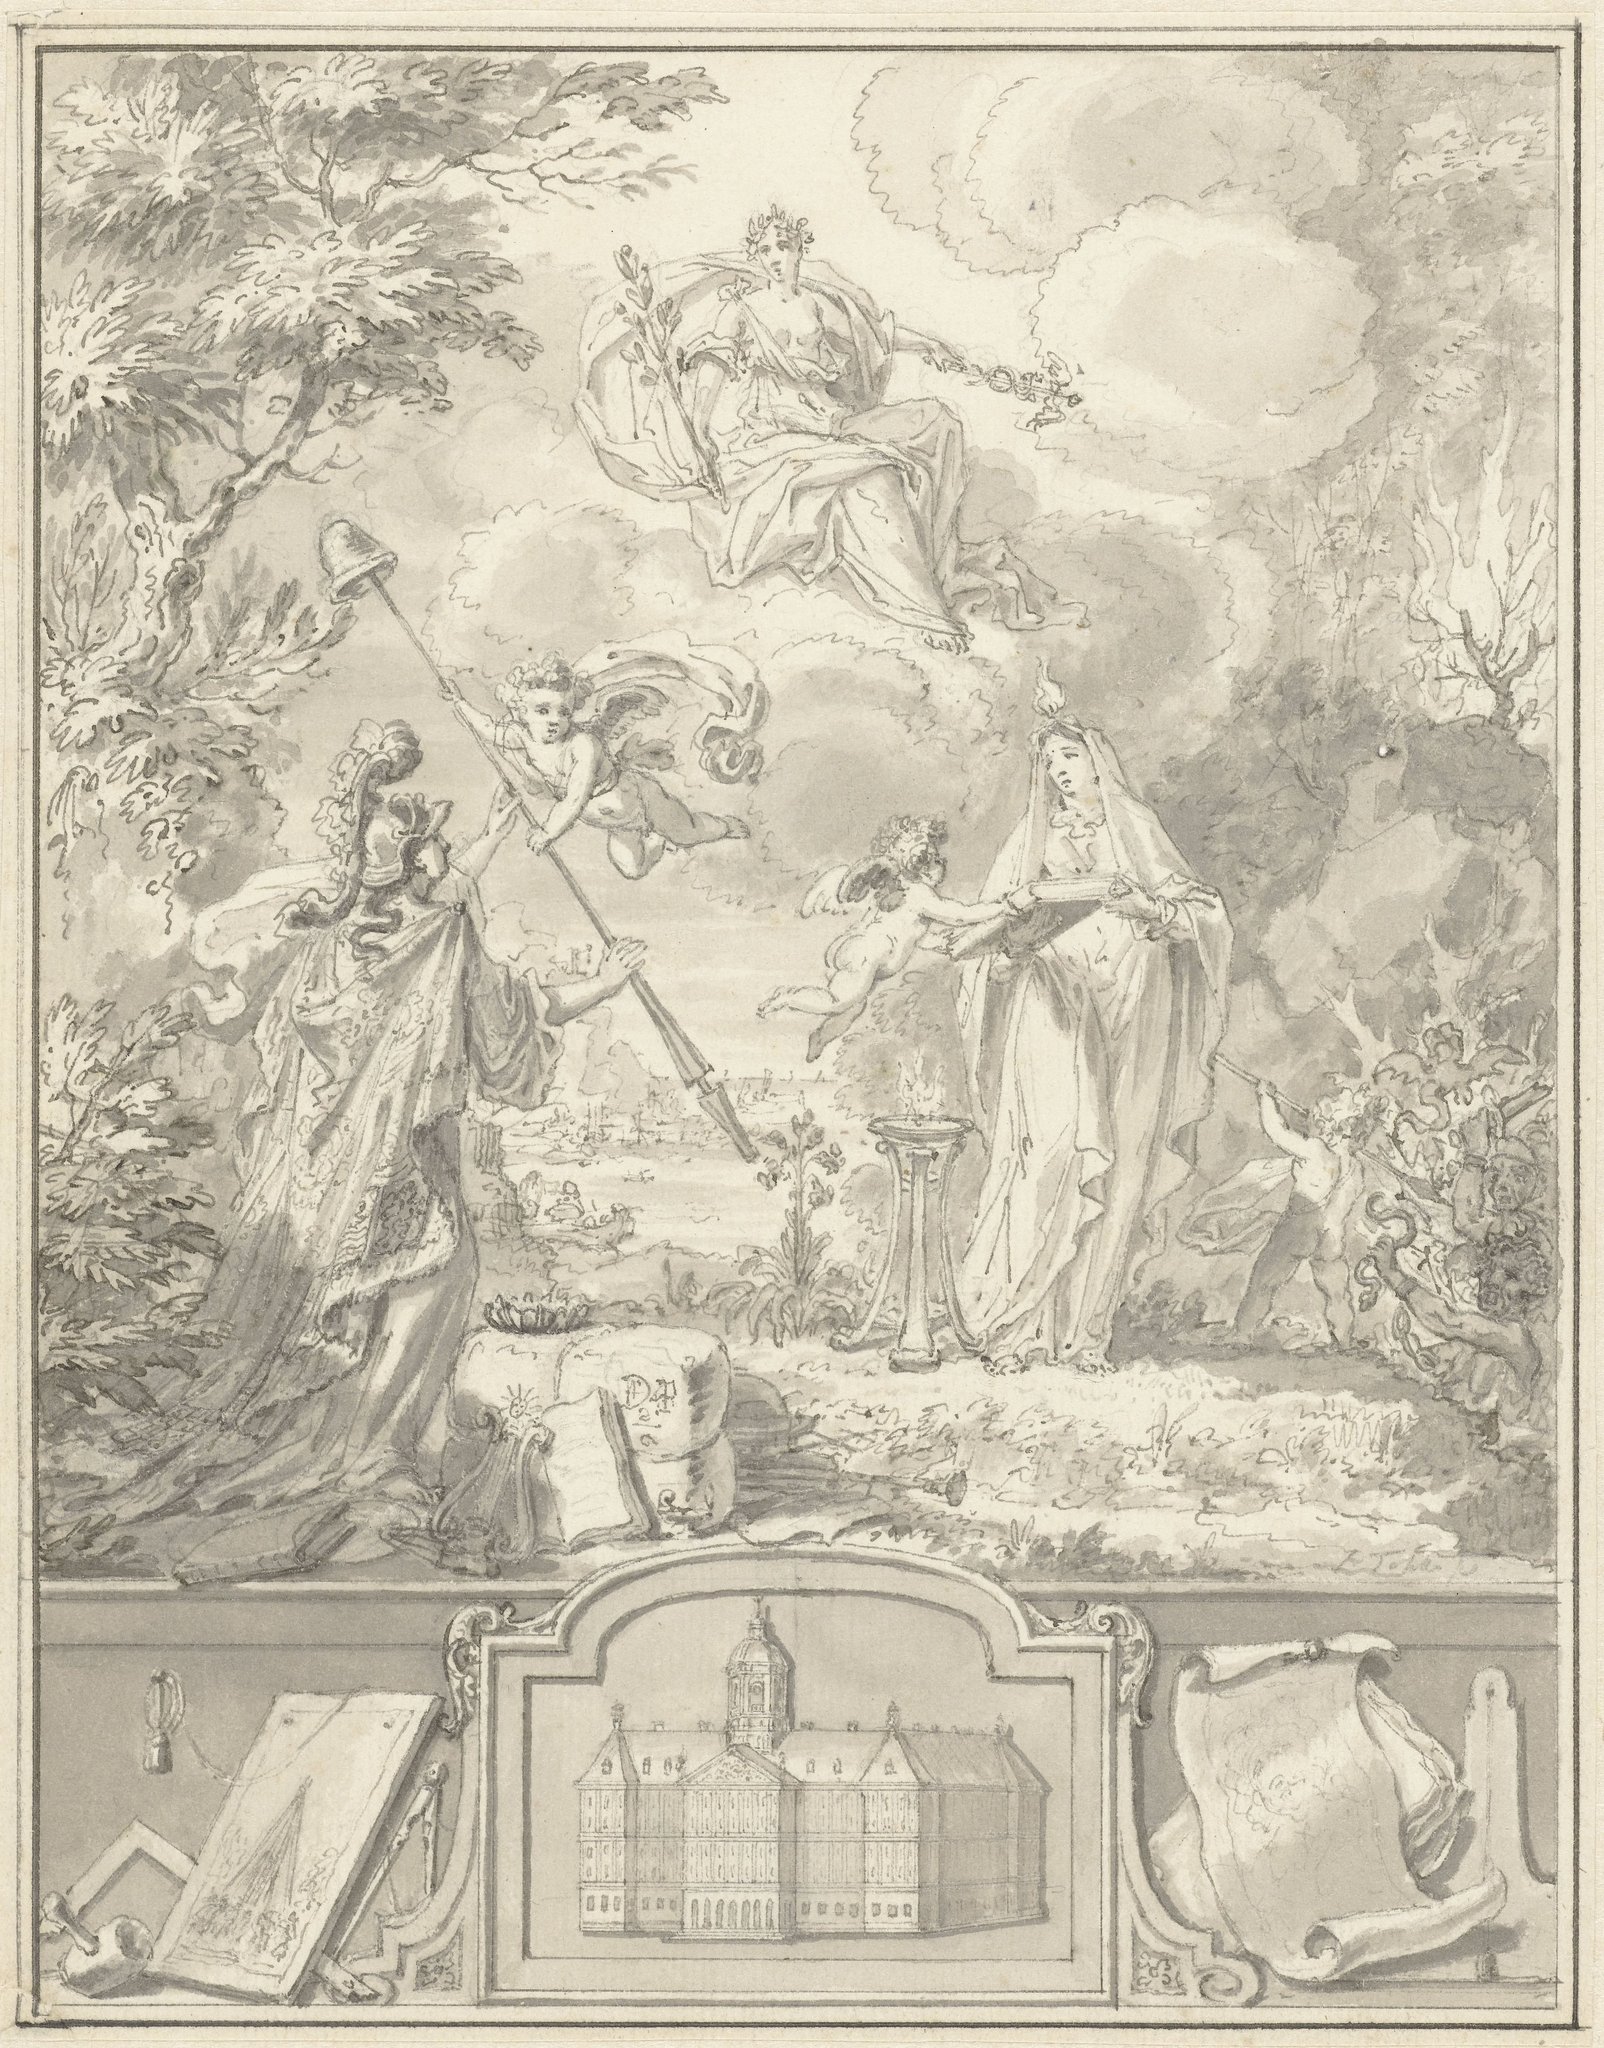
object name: design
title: Allegorie op het 100-jarig jubileum van Nederlands Vrijheid, 1648-1748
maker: simon fokke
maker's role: draughtsman, print maker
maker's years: 1712-1784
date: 1748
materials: paper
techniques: pouncing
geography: northern netherlands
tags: townhall, freedom, liberty; 'libertà' (ripa), signing of peace treaty, concluding the peace, royal palace of amsterdam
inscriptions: collector's mark: Lugt 2228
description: De gelauwerde personificatie van de Vrede troont in de lucht met een olijftak en een caduceus. Onder haar ontvangt Minerva een lans met vrijheidshoed van een putto. Een tweede putto biedt de Waakzaamheid in het midden een boek aan. Geheel links jaagt een derde putto duivelse figuren met een speer een vlammenzee in. Aan de onderzijde het in 1648 voltooide Stadhuis op de Dam te Amsterdam met een portret van Jacob van Campen en een voorstelling van heiwerkzaamheden bij de bouw.